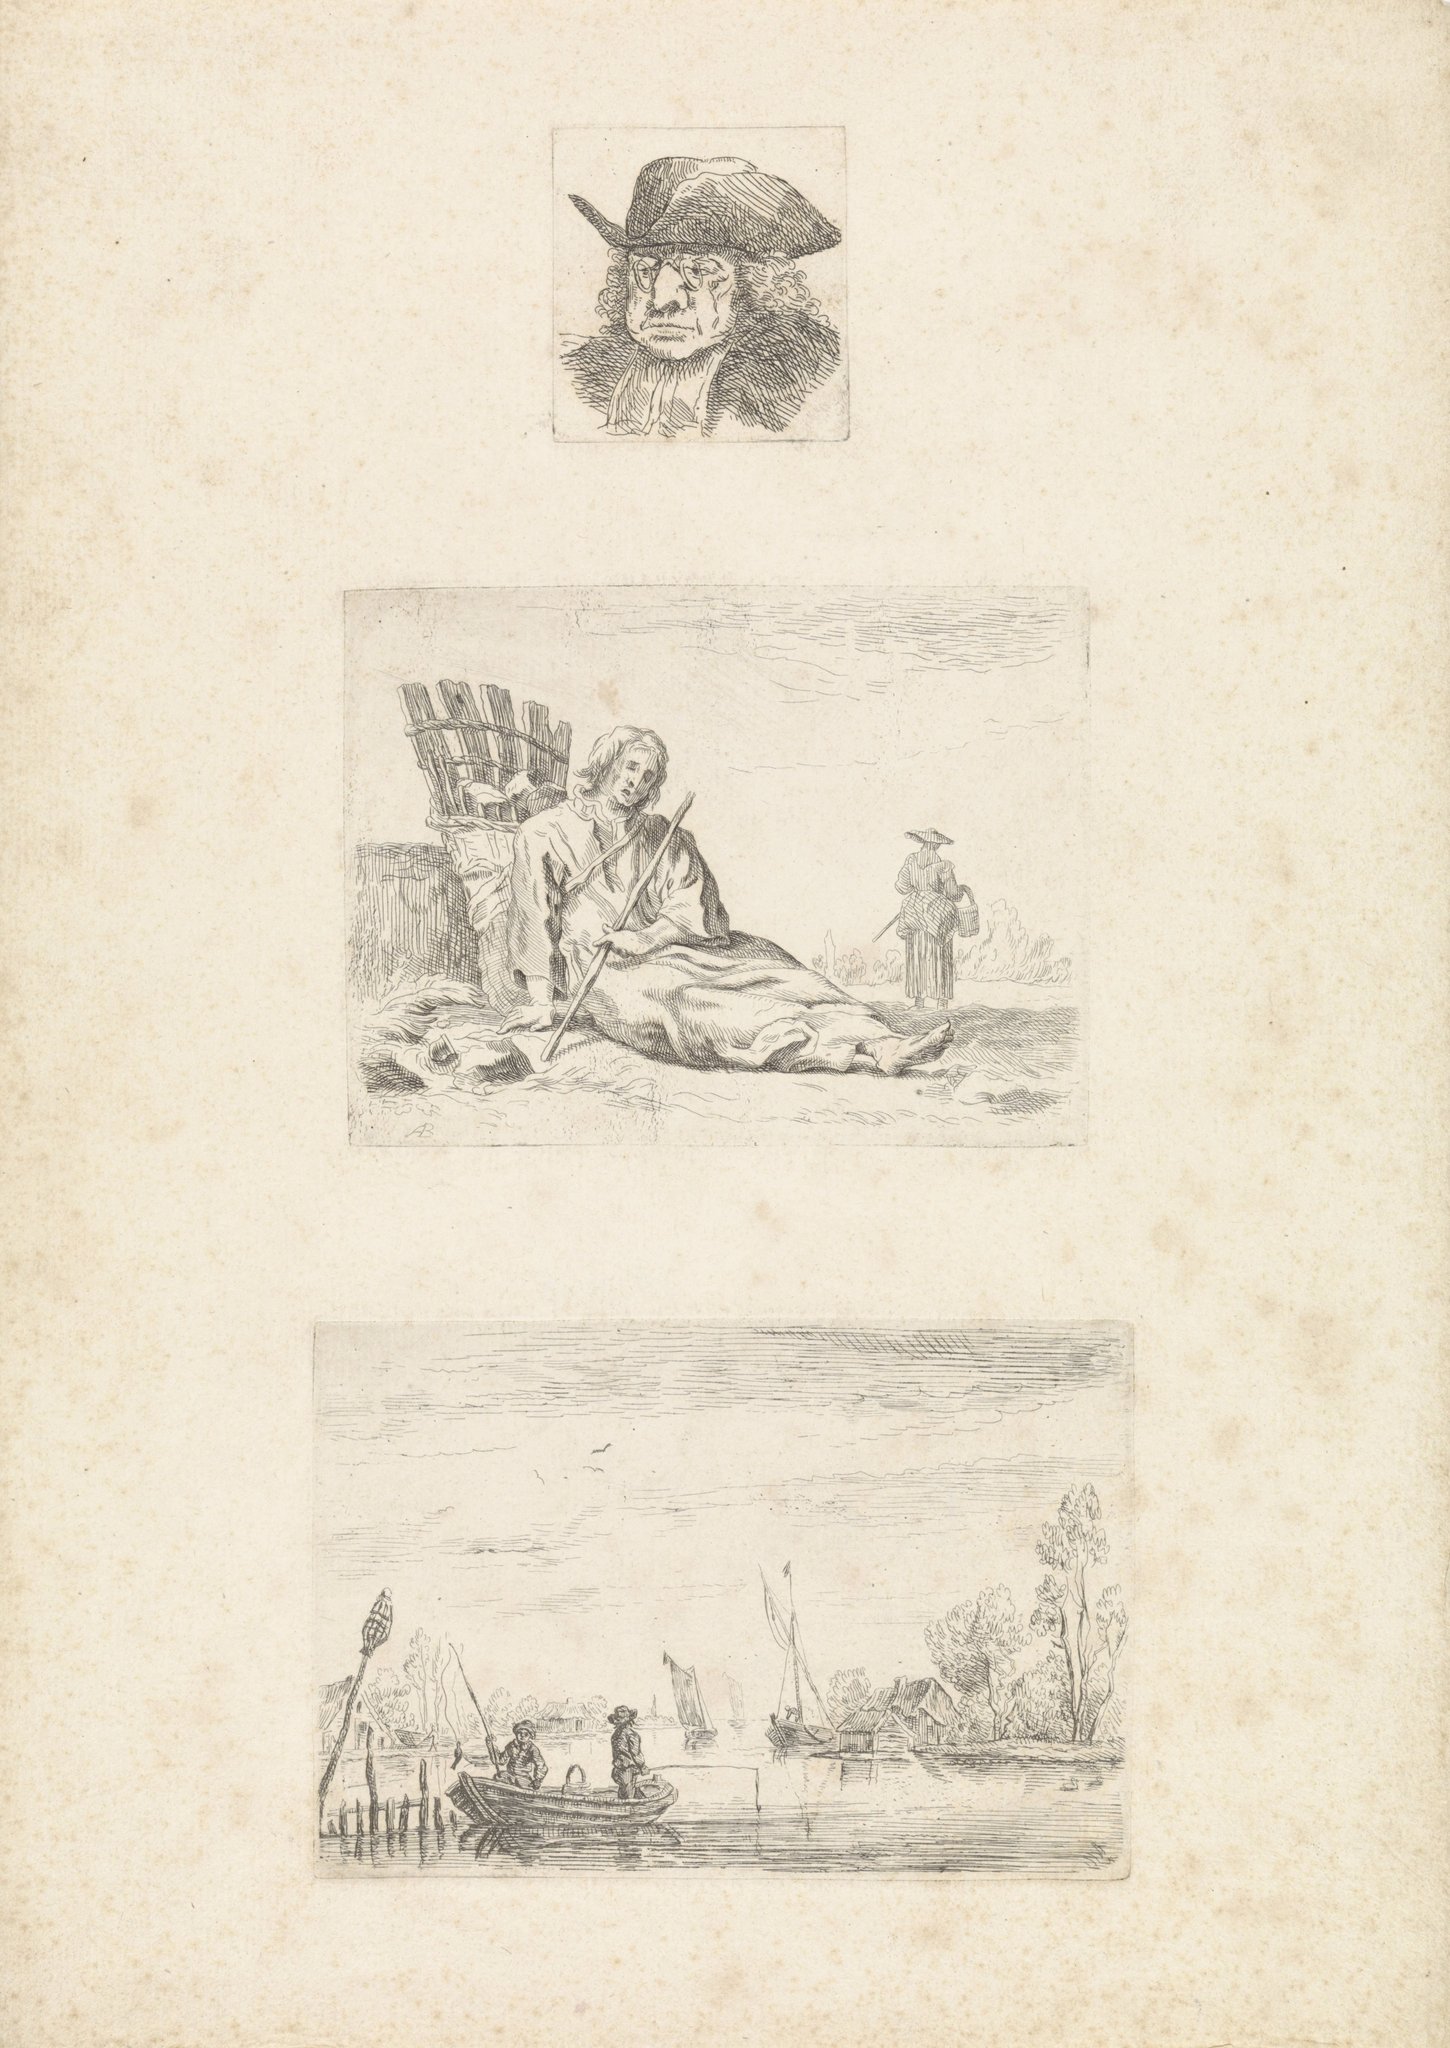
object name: print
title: Portret van Abraham van Wielen / Landschap met herder / Rivierlandschap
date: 1727-1769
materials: paper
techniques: engraving, etching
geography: leiden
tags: herding, herdsman, herdswoman, shepherd, shepherdess, cowherd, etc., rowing-boat, canoe, etc.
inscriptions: collector's mark: Lugt 2228, inscription: ‘Warvis’, collector's mark: Lugt 2760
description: Drie prenten op een blad. Boven: busteportret van Abraham van Wielen, met hoed, naar links. Midden: Landschap met een liggende herder. Op de achtergrond een vrouw, op de rug gezien. Onder: rivierlandschap met op de voorgrond een roeiboot met twee vissers.